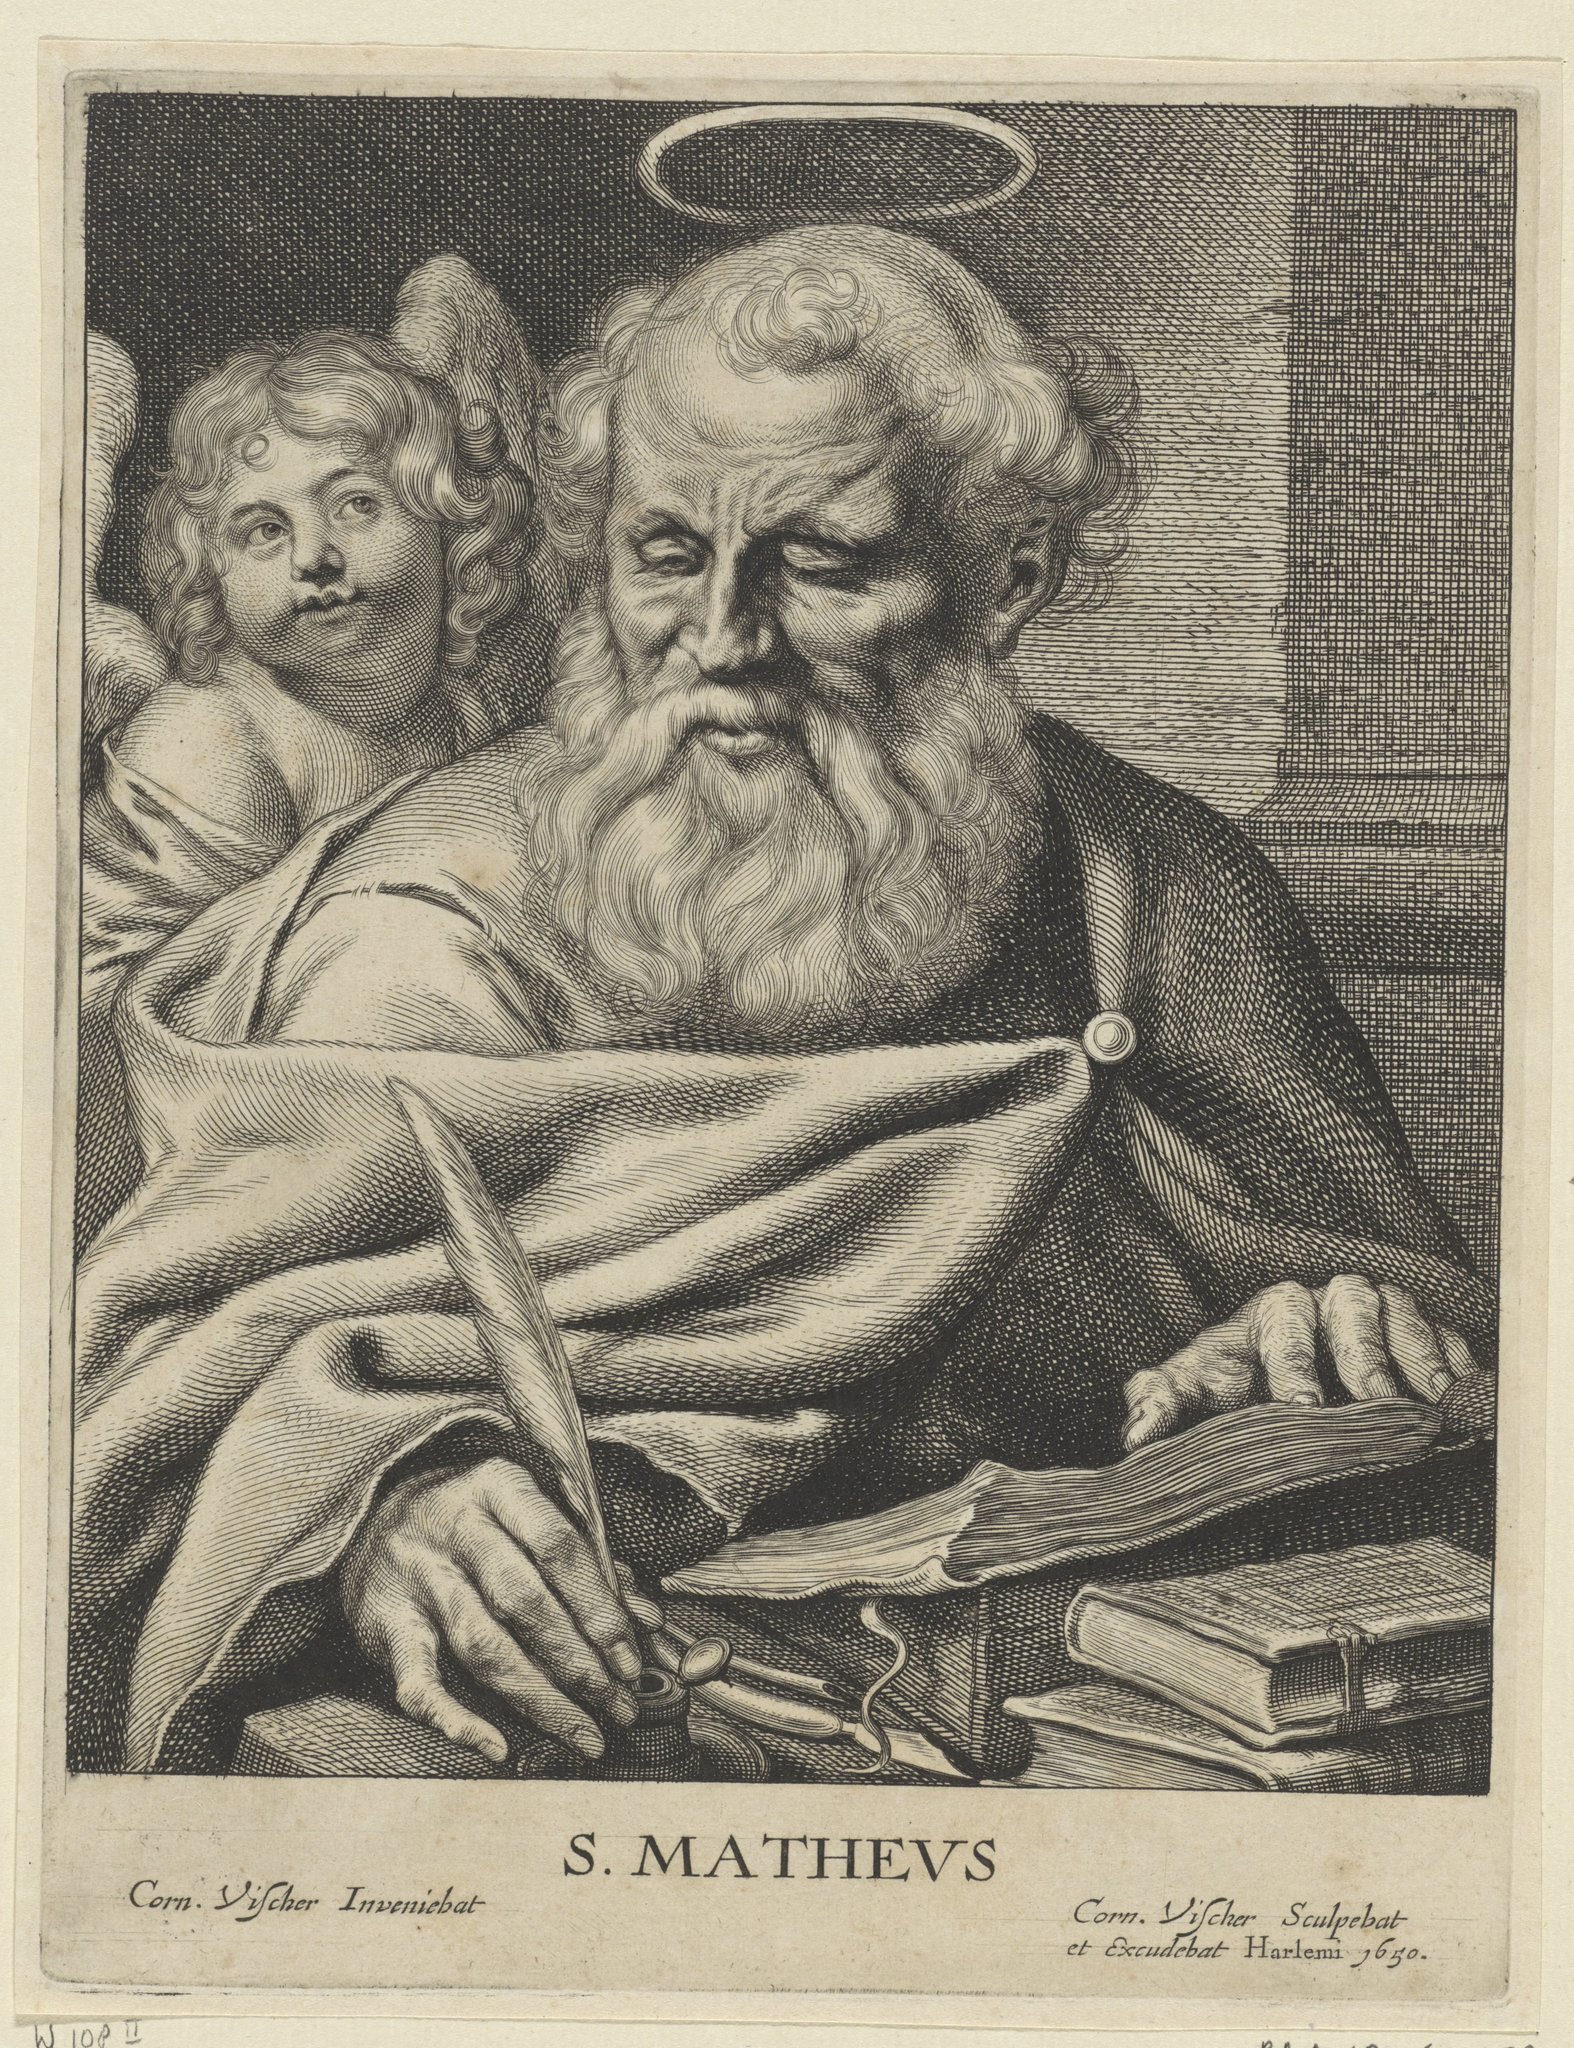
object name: print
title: S. MATHEVS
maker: cornelis visscher (ii)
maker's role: draughtsman, painter, print maker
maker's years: 1628-1658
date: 1650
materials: paper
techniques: engraving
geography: haarlem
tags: the apostle and evangelist matthew (mattheus); possible attributes: angel, axe, book, halberd, pen and inkhorn, purse, scroll, square, sword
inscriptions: collector's mark: Lugt 240